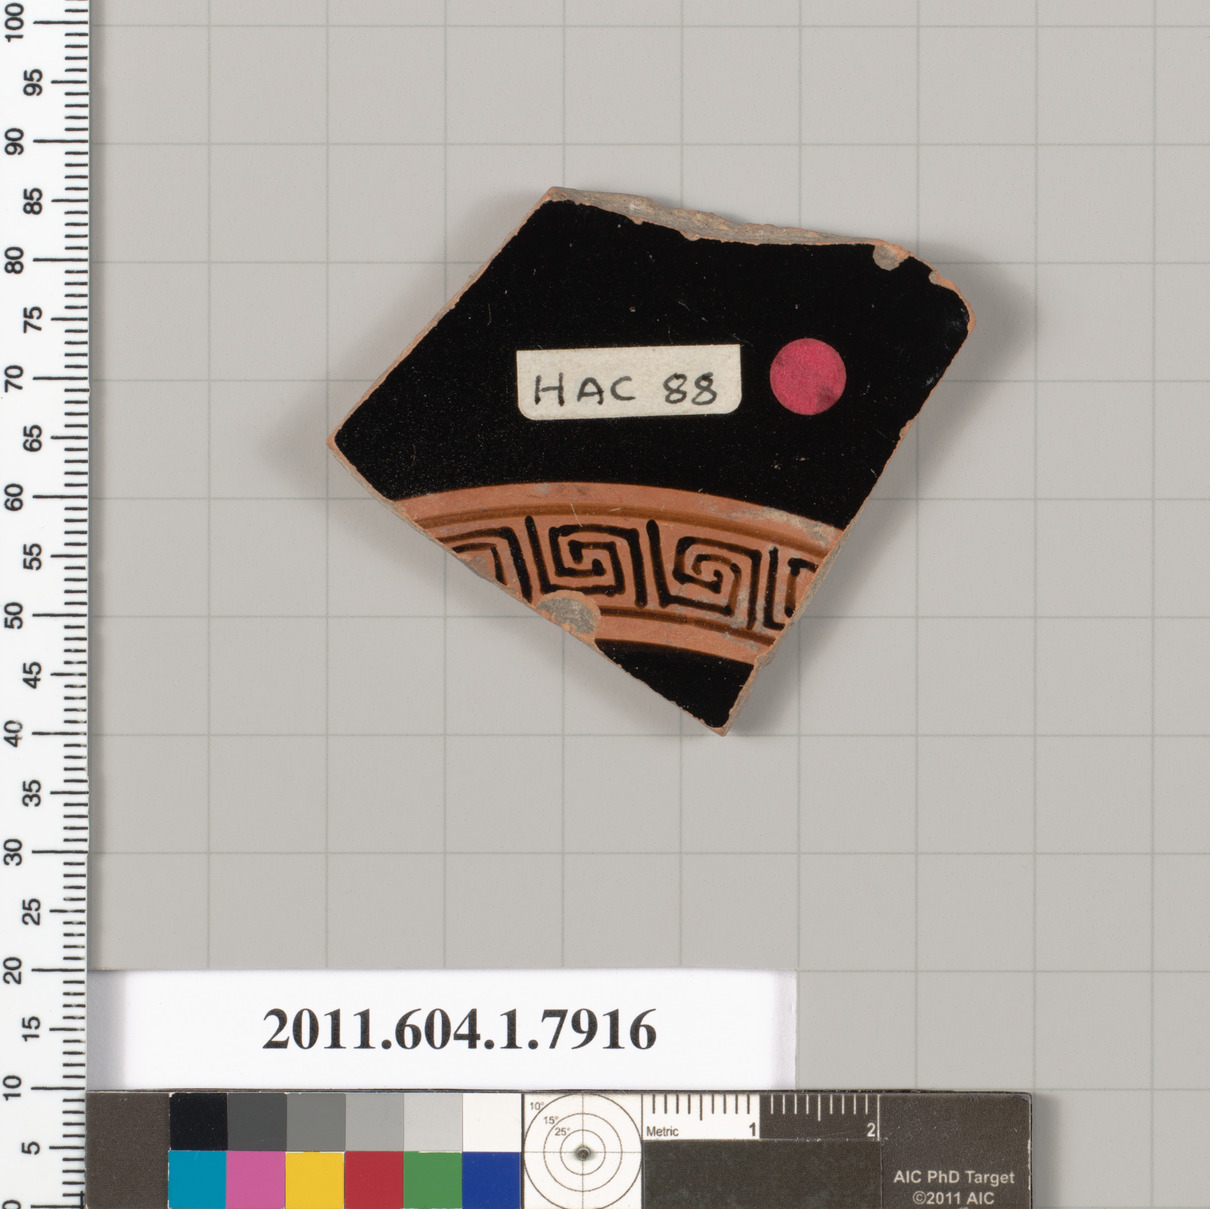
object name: kylix fragment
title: Terracotta fragment of a kylix (drinking cup)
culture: greek, attic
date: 460-450 BCE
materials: terracotta